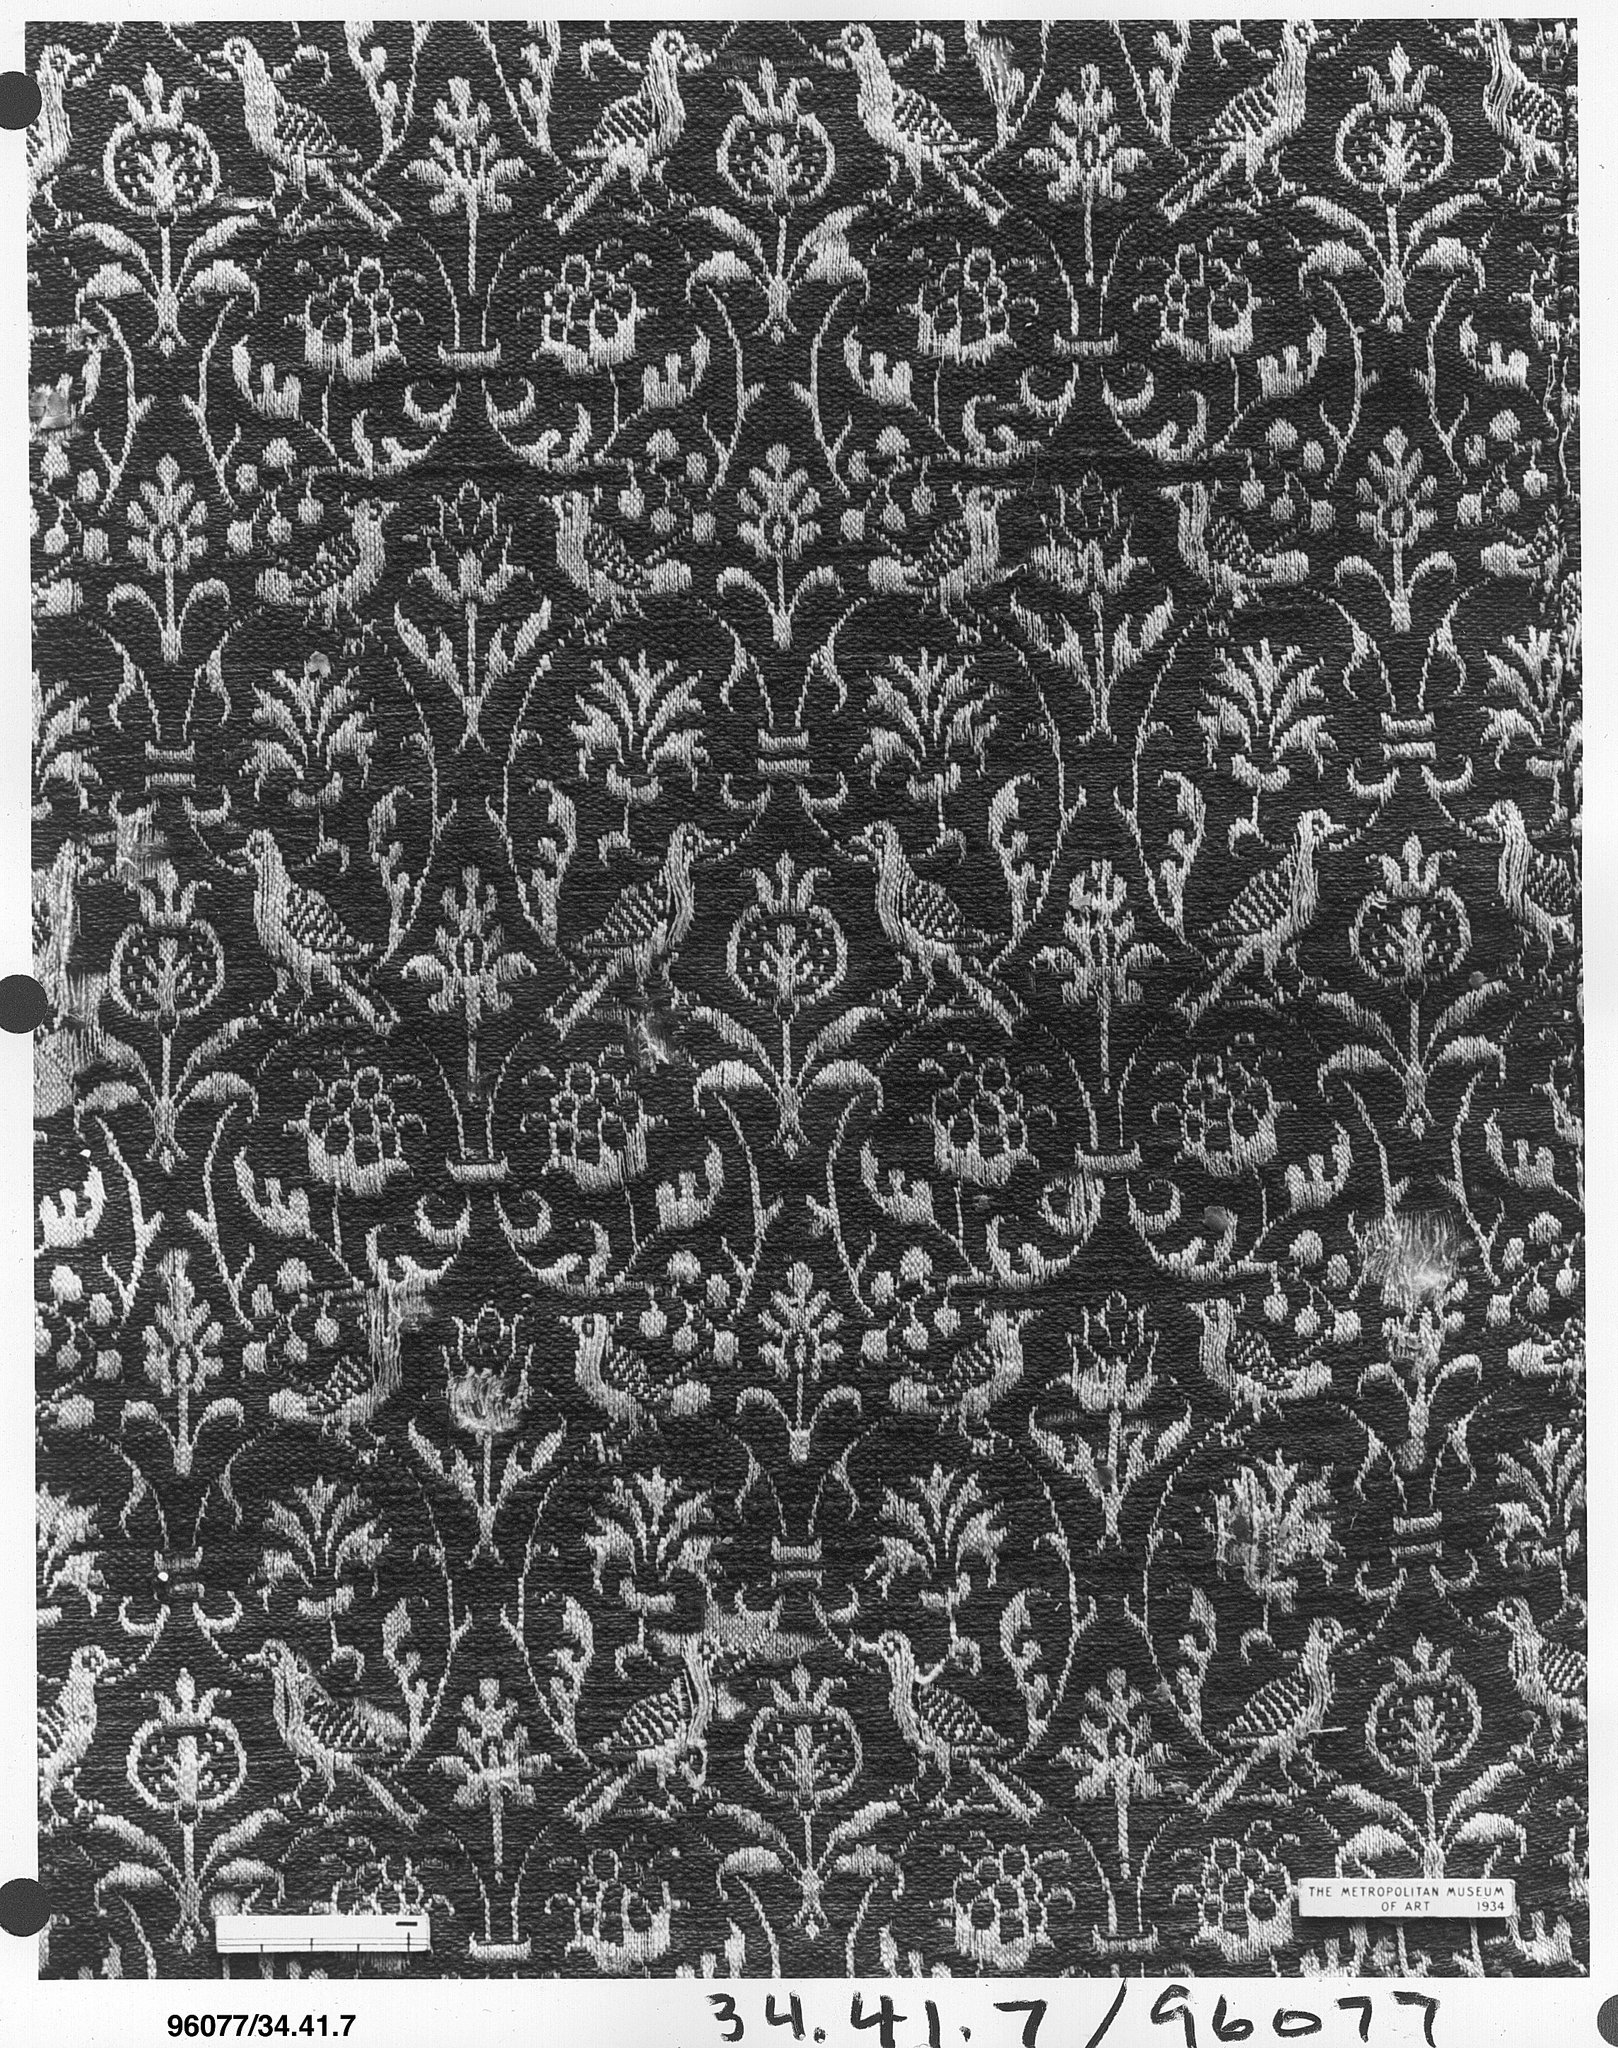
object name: piece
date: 1501-1600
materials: textile, linen, wool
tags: birds